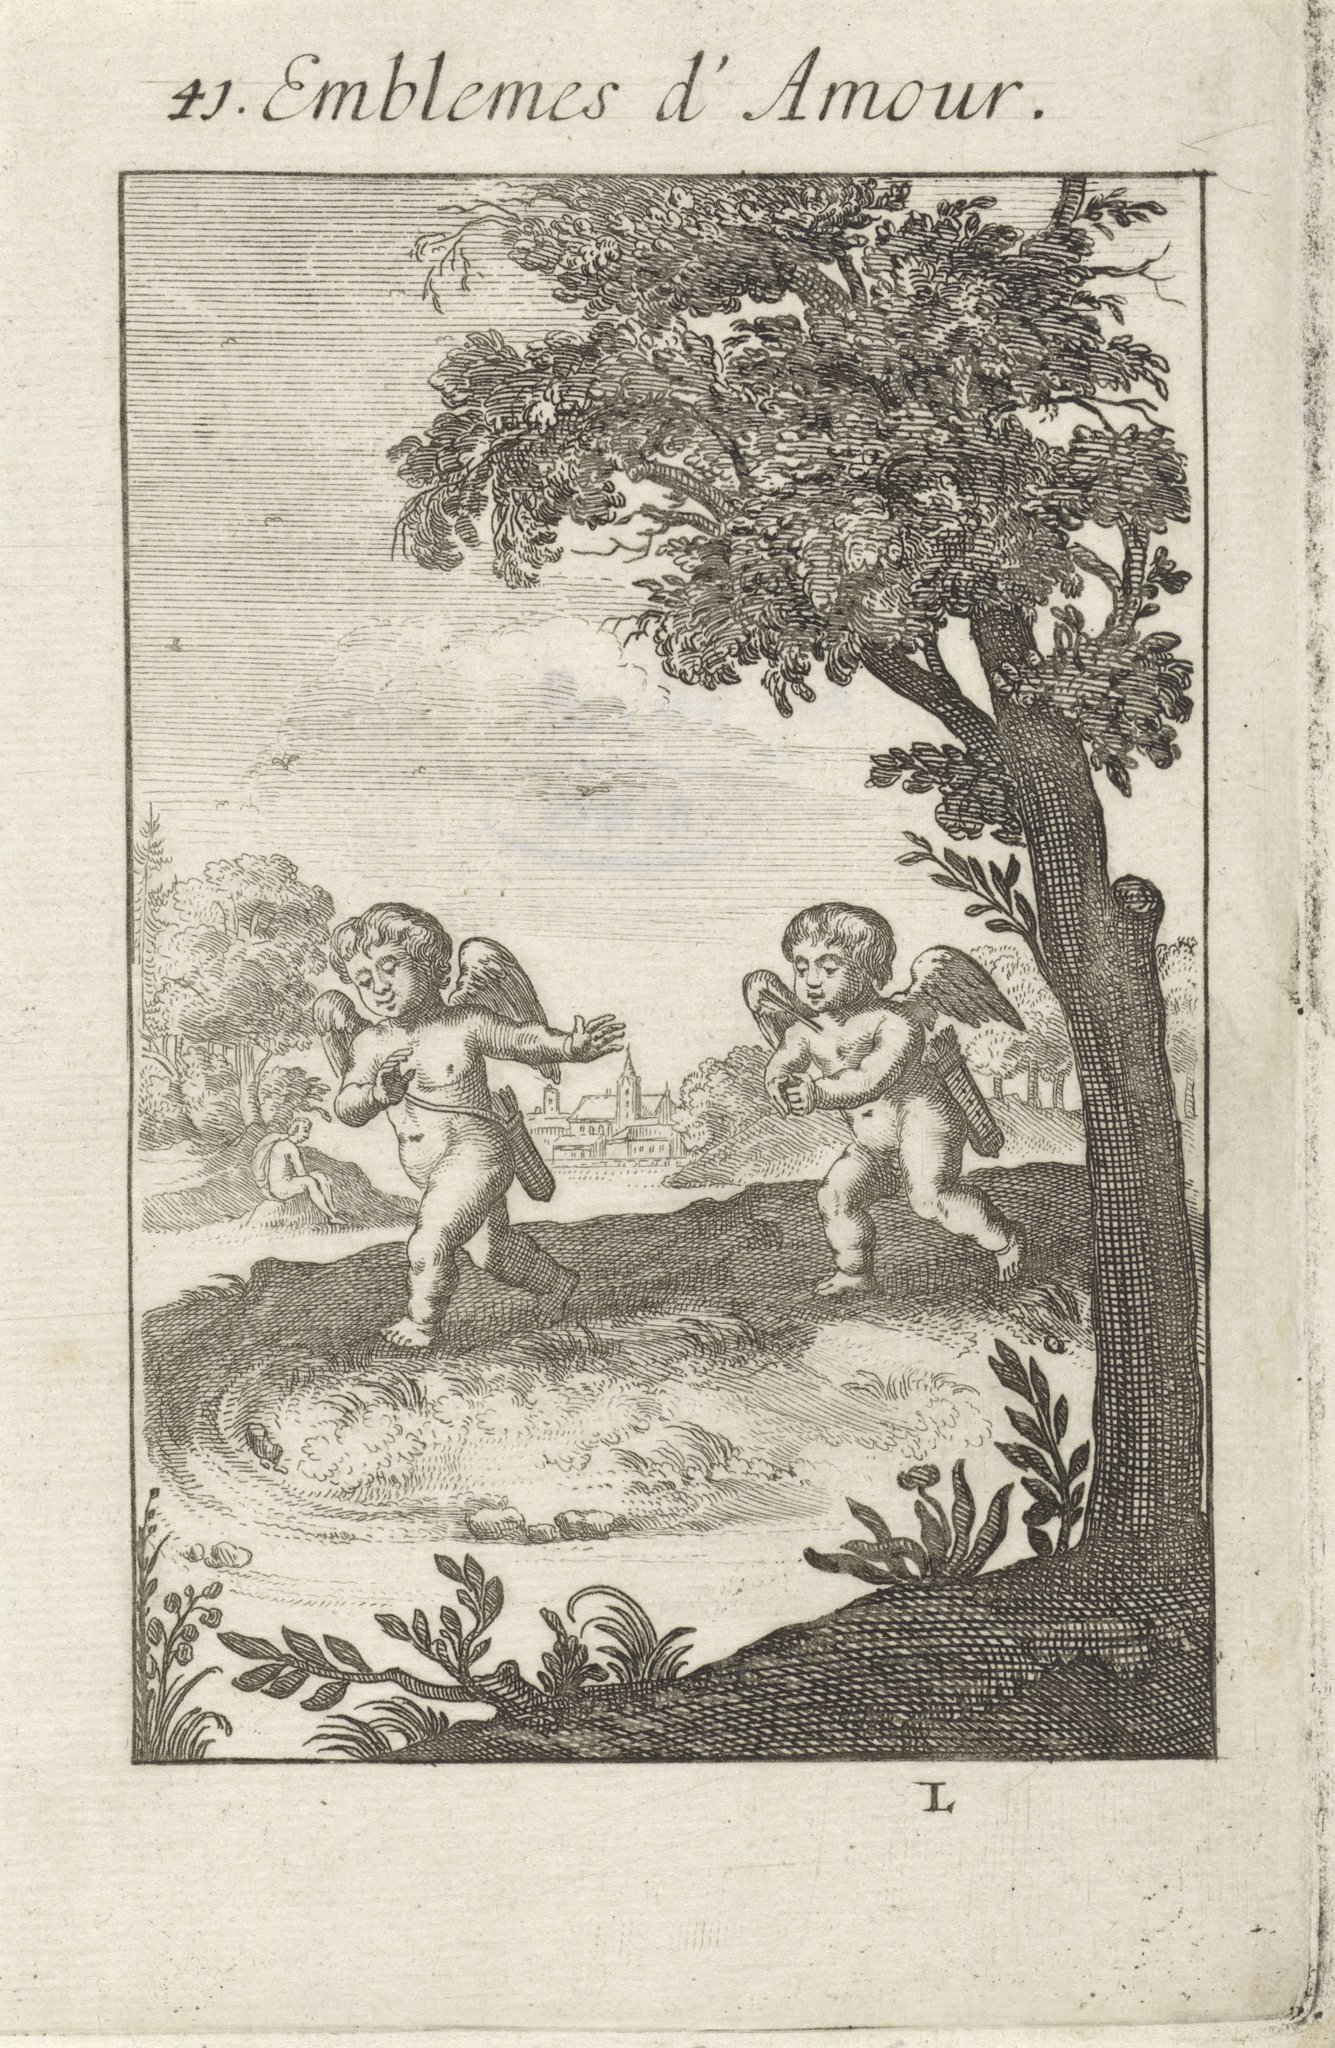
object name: print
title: Putto loopt verliefd een andere putto na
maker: jan van vianen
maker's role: print maker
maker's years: 1660-1726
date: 1686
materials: paper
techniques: etching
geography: northern netherlands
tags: love torturing lover, (story of) cupid, amor (eros), cupids: 'amores', 'amoretti', 'putti'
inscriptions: collector's mark: Lugt 2228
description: Een putto met een pijl in zijn borst loopt met gevouwen handen achter een ander putto aan, die een afwijzend gebaar maakt. Zoals geweld een lichaam beschadigt, zo kan de liefde een hart pijn doen. Op de achtergrond een eenzame figuur in een landschap. Eenenveertigste embleem uit Emblemata Amatoria.